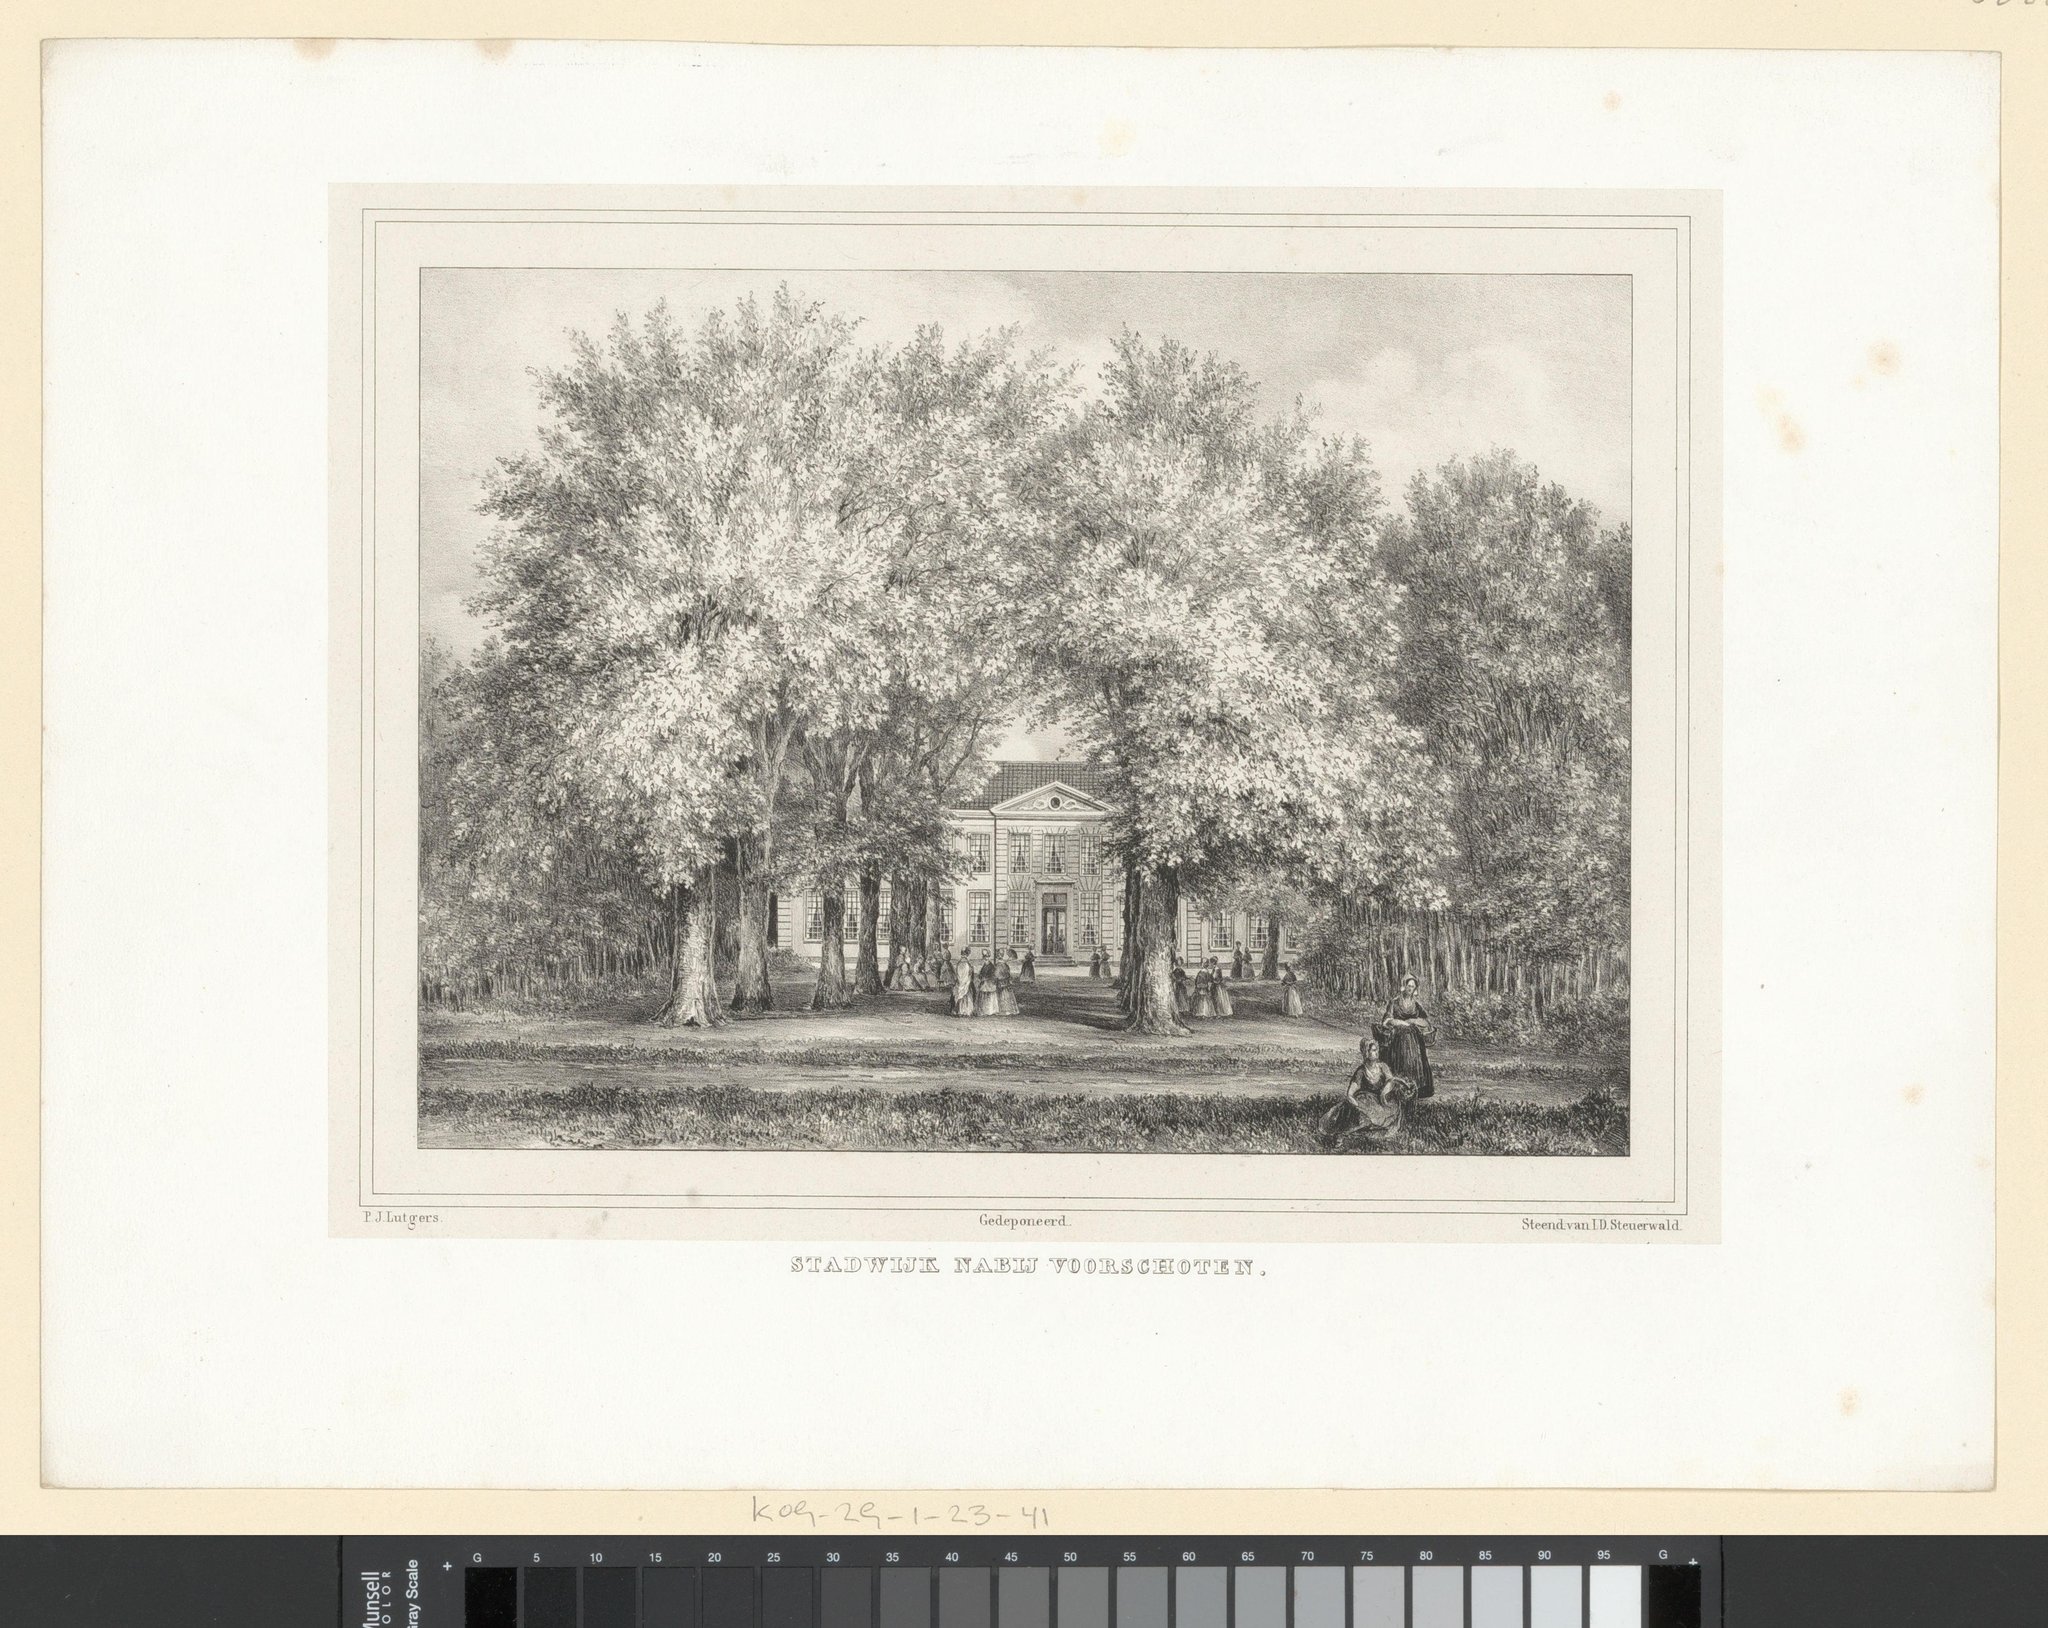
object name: print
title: Gezicht op buitenplaats Stadwijk te Voorschoten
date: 1855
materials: paper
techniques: lithograph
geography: the hague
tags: trees, farm or solitary house in landscape, voorschoten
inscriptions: stamp, : ‘Gedeponeerd’, collector's mark: Lugt 1641, stamp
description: Onderwerpsrubrieken binnen de Atlas Zeden en Gewoonten: Zeden en Gewoonten in Engeren Zin, De Woning. Kastelen en buitenplaatsen. Holland.